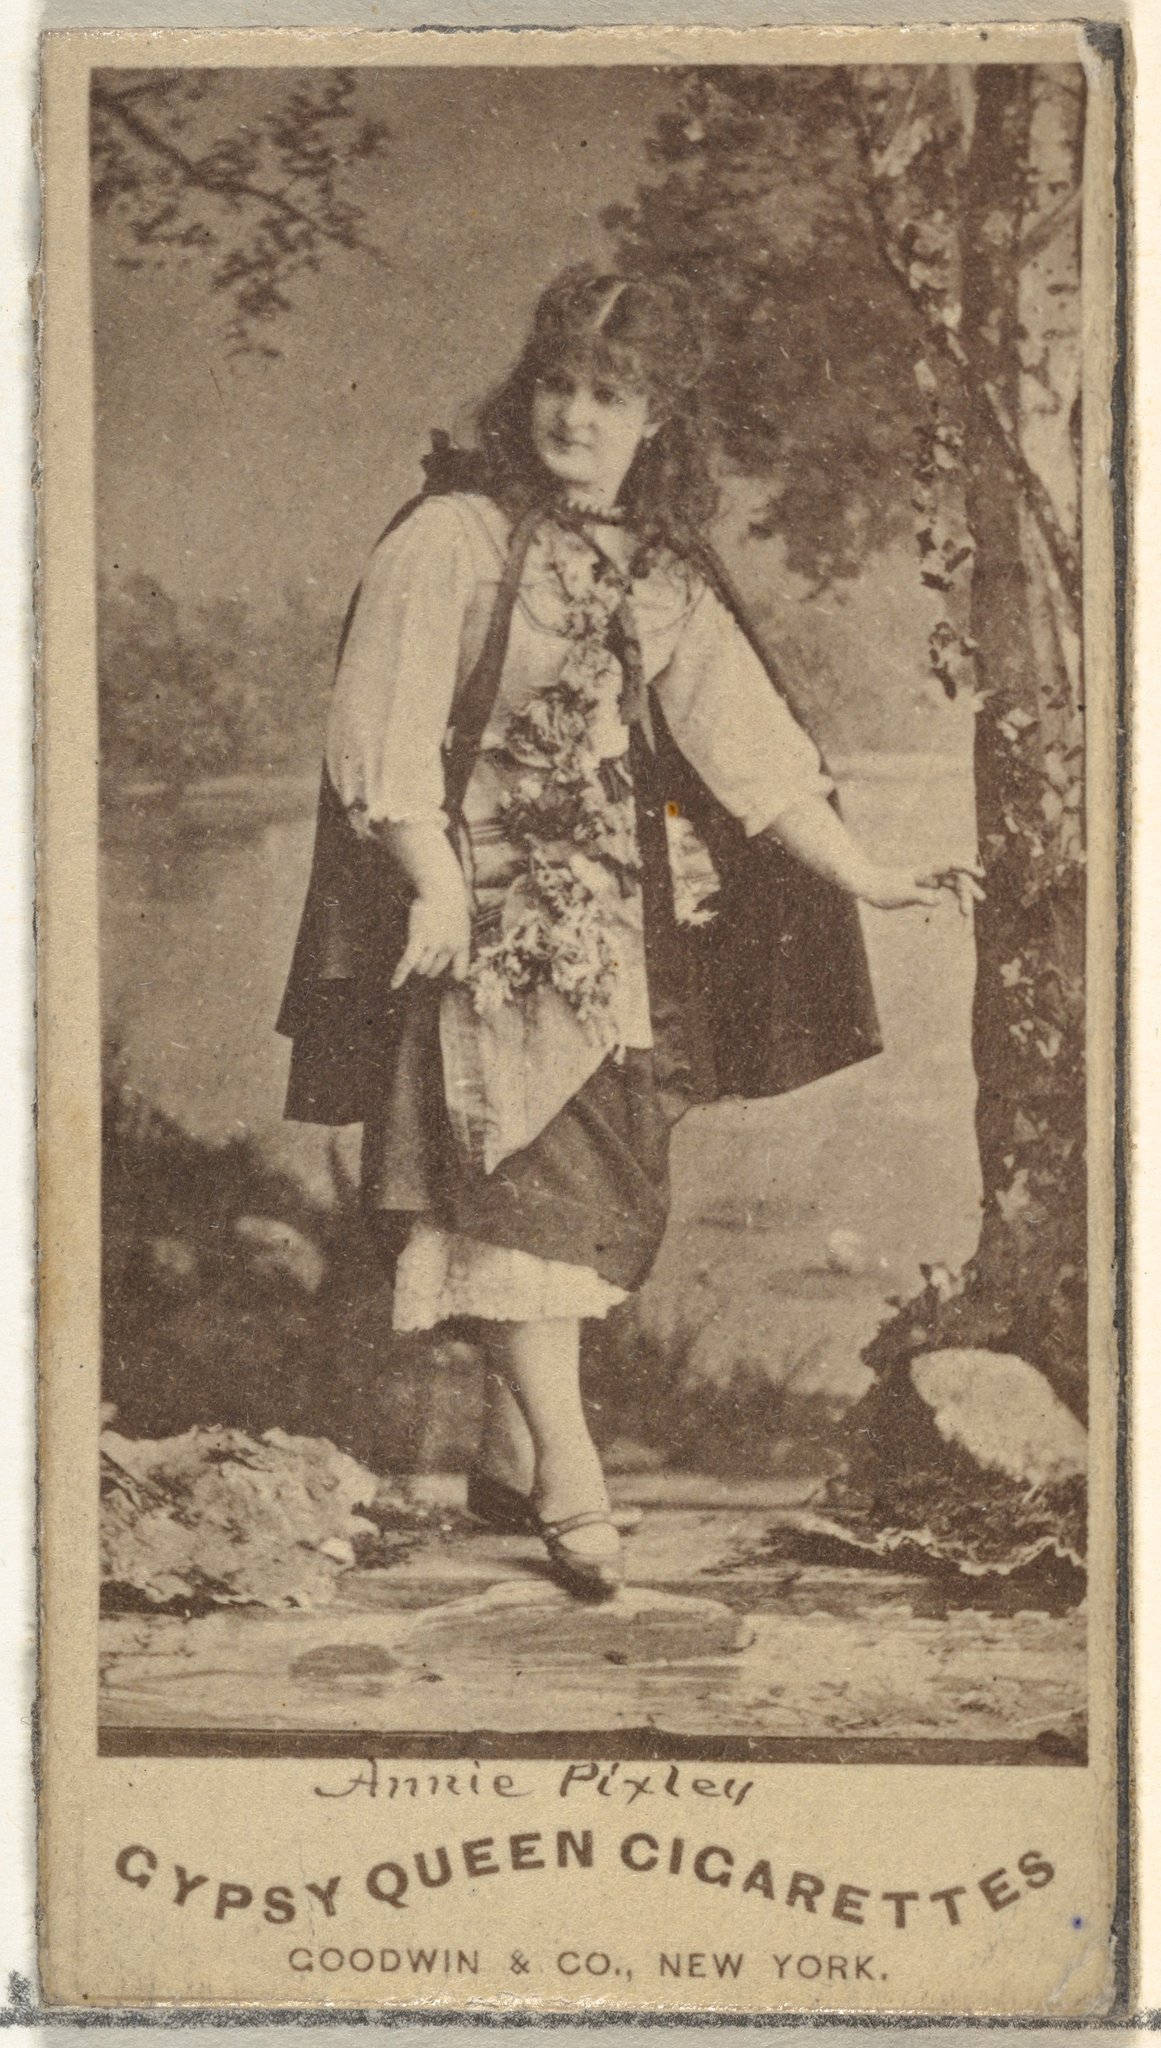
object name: photograph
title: Annie Pixley, from the Actors and Actresses series (N171) for Gypsy Queen Cigarettes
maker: goodwin & company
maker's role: publisher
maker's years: 1850-1950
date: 1886-1890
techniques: albumen silver print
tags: portraits,women,actresses